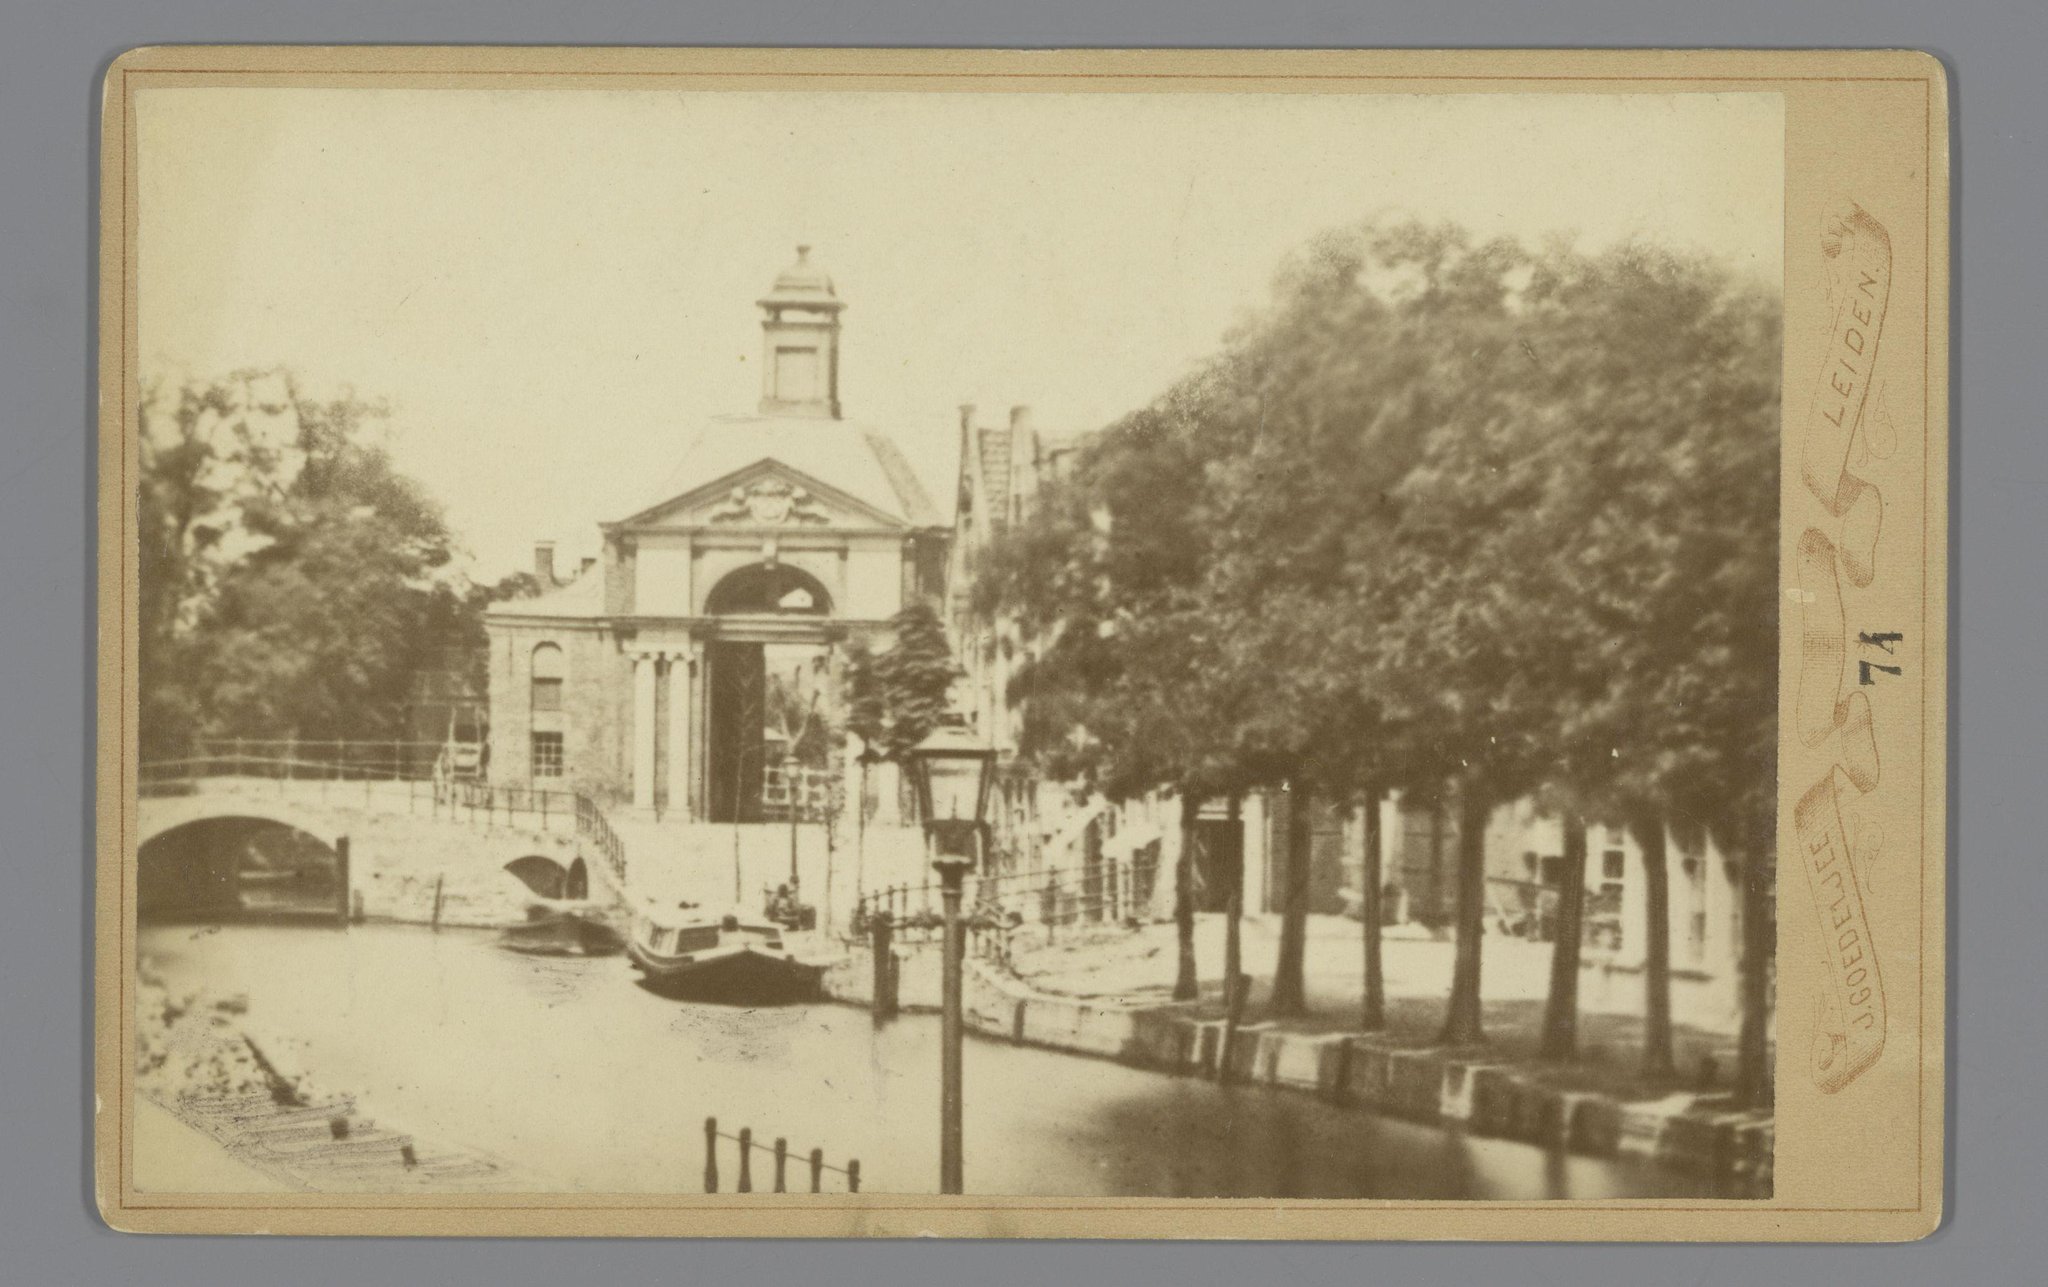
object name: photograph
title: Gezicht op de Marepoort te Leiden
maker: jan goedeljee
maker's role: fotograaf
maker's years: 1824-1905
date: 1860-1864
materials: cardboard, photographic support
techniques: albumen print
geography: leiden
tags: city-gate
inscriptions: inscription: ‘J. Goedeljee (...) Leiden/ Hoogewoerd 160/ naby de Plantage’, inscription: ‘J. Goedeljee/ Leiden/ 74’